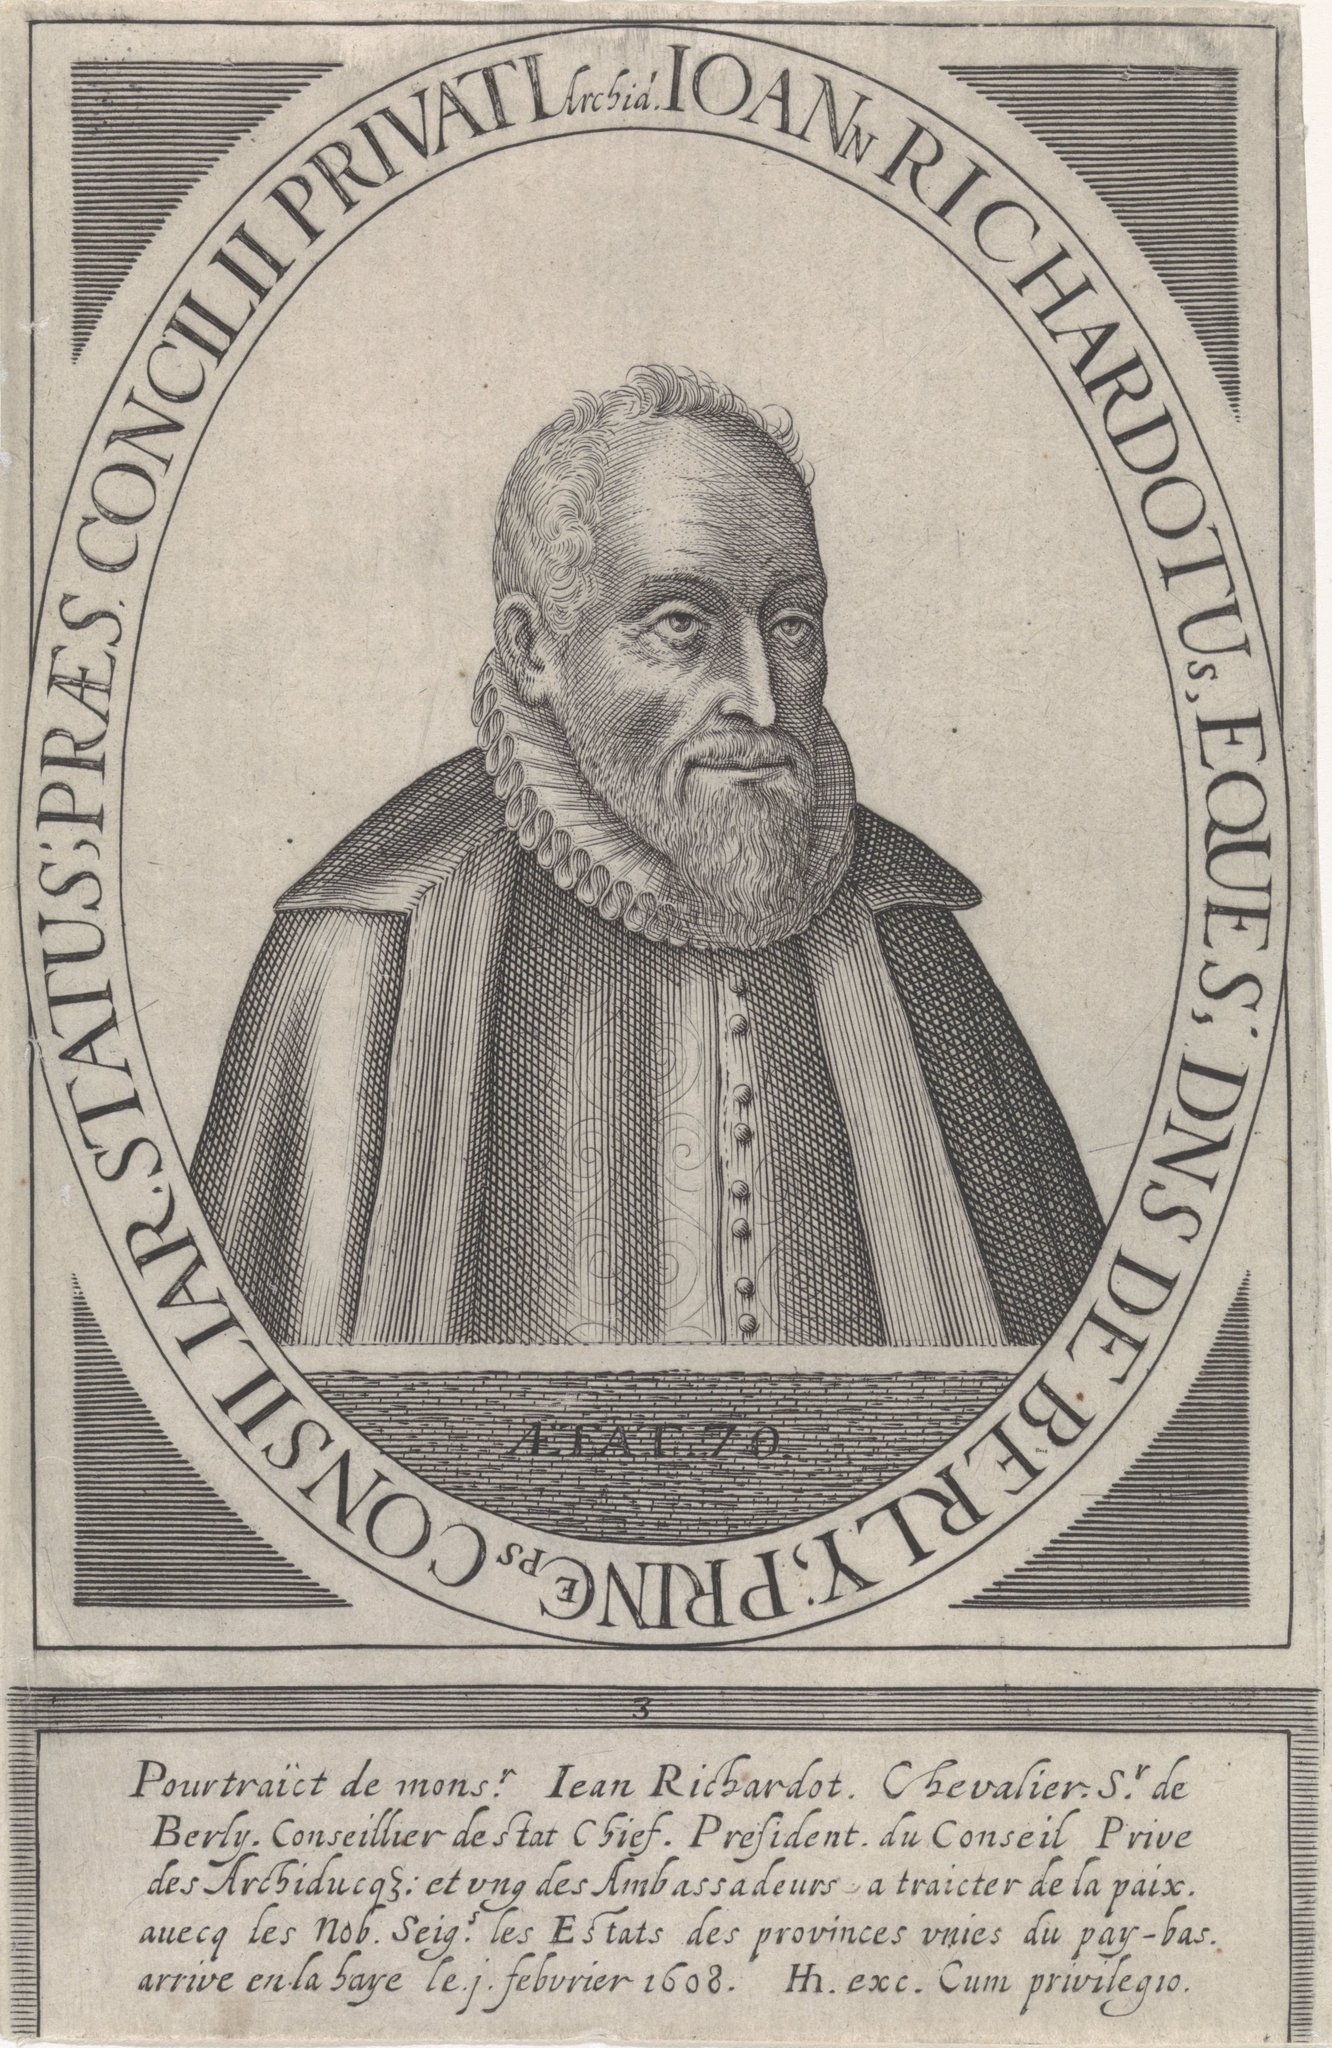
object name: print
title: Portret van Jean Richardot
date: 1608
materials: paper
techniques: engraving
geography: the hague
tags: jean richardot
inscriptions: collector's mark: Lugt 2228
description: Buste naar rechts van Jean Richardot, in een ovale omlijsting, waarop een randschrift met zijn naam en titel in het Latijn. Onder het portret vijf regels in het Frans. Prent uit een serie van veertig portretten van vredestichters in de Nederlanden. Tevens een van de vijf genummerde prenten uit deze serie, tezamen apart uitgegeven na 1609.